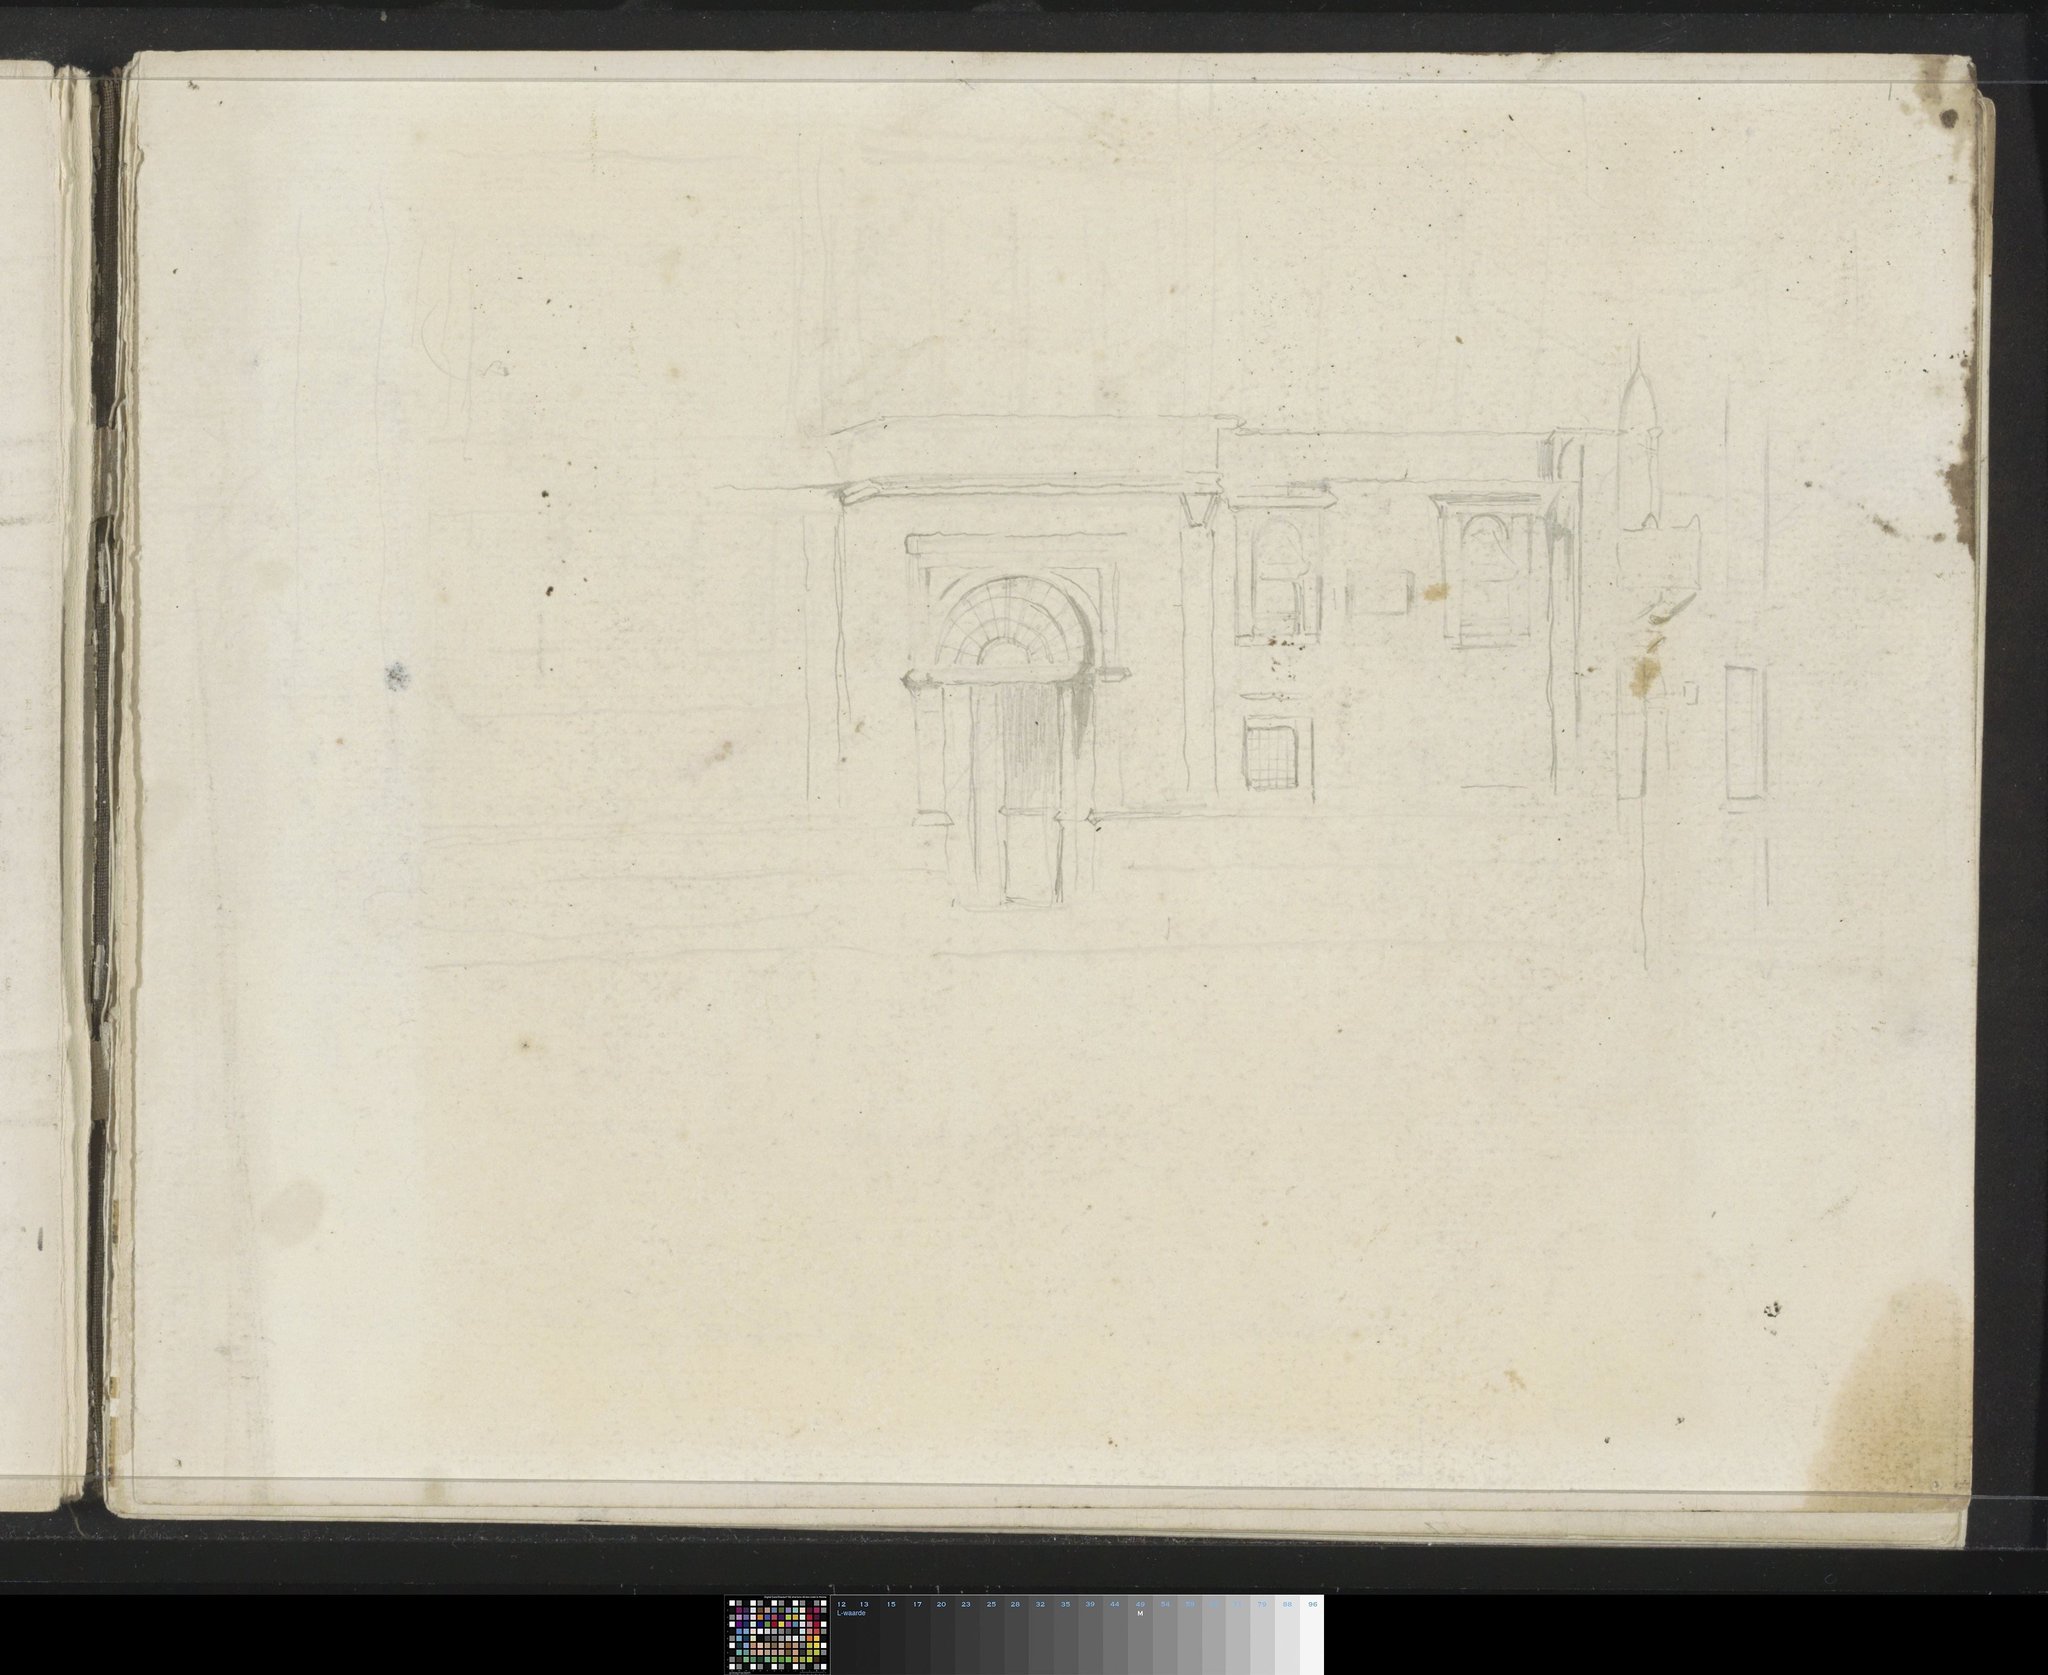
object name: sketchbook leaf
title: Gebouw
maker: willem witsen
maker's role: draughtsman, painter, print maker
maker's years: 1860-1923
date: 1910-1915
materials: paper, pencil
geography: san francisco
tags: civic architecture; edifices; dwellings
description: Pagina 1 uit een schetsboek met 18 bladen.